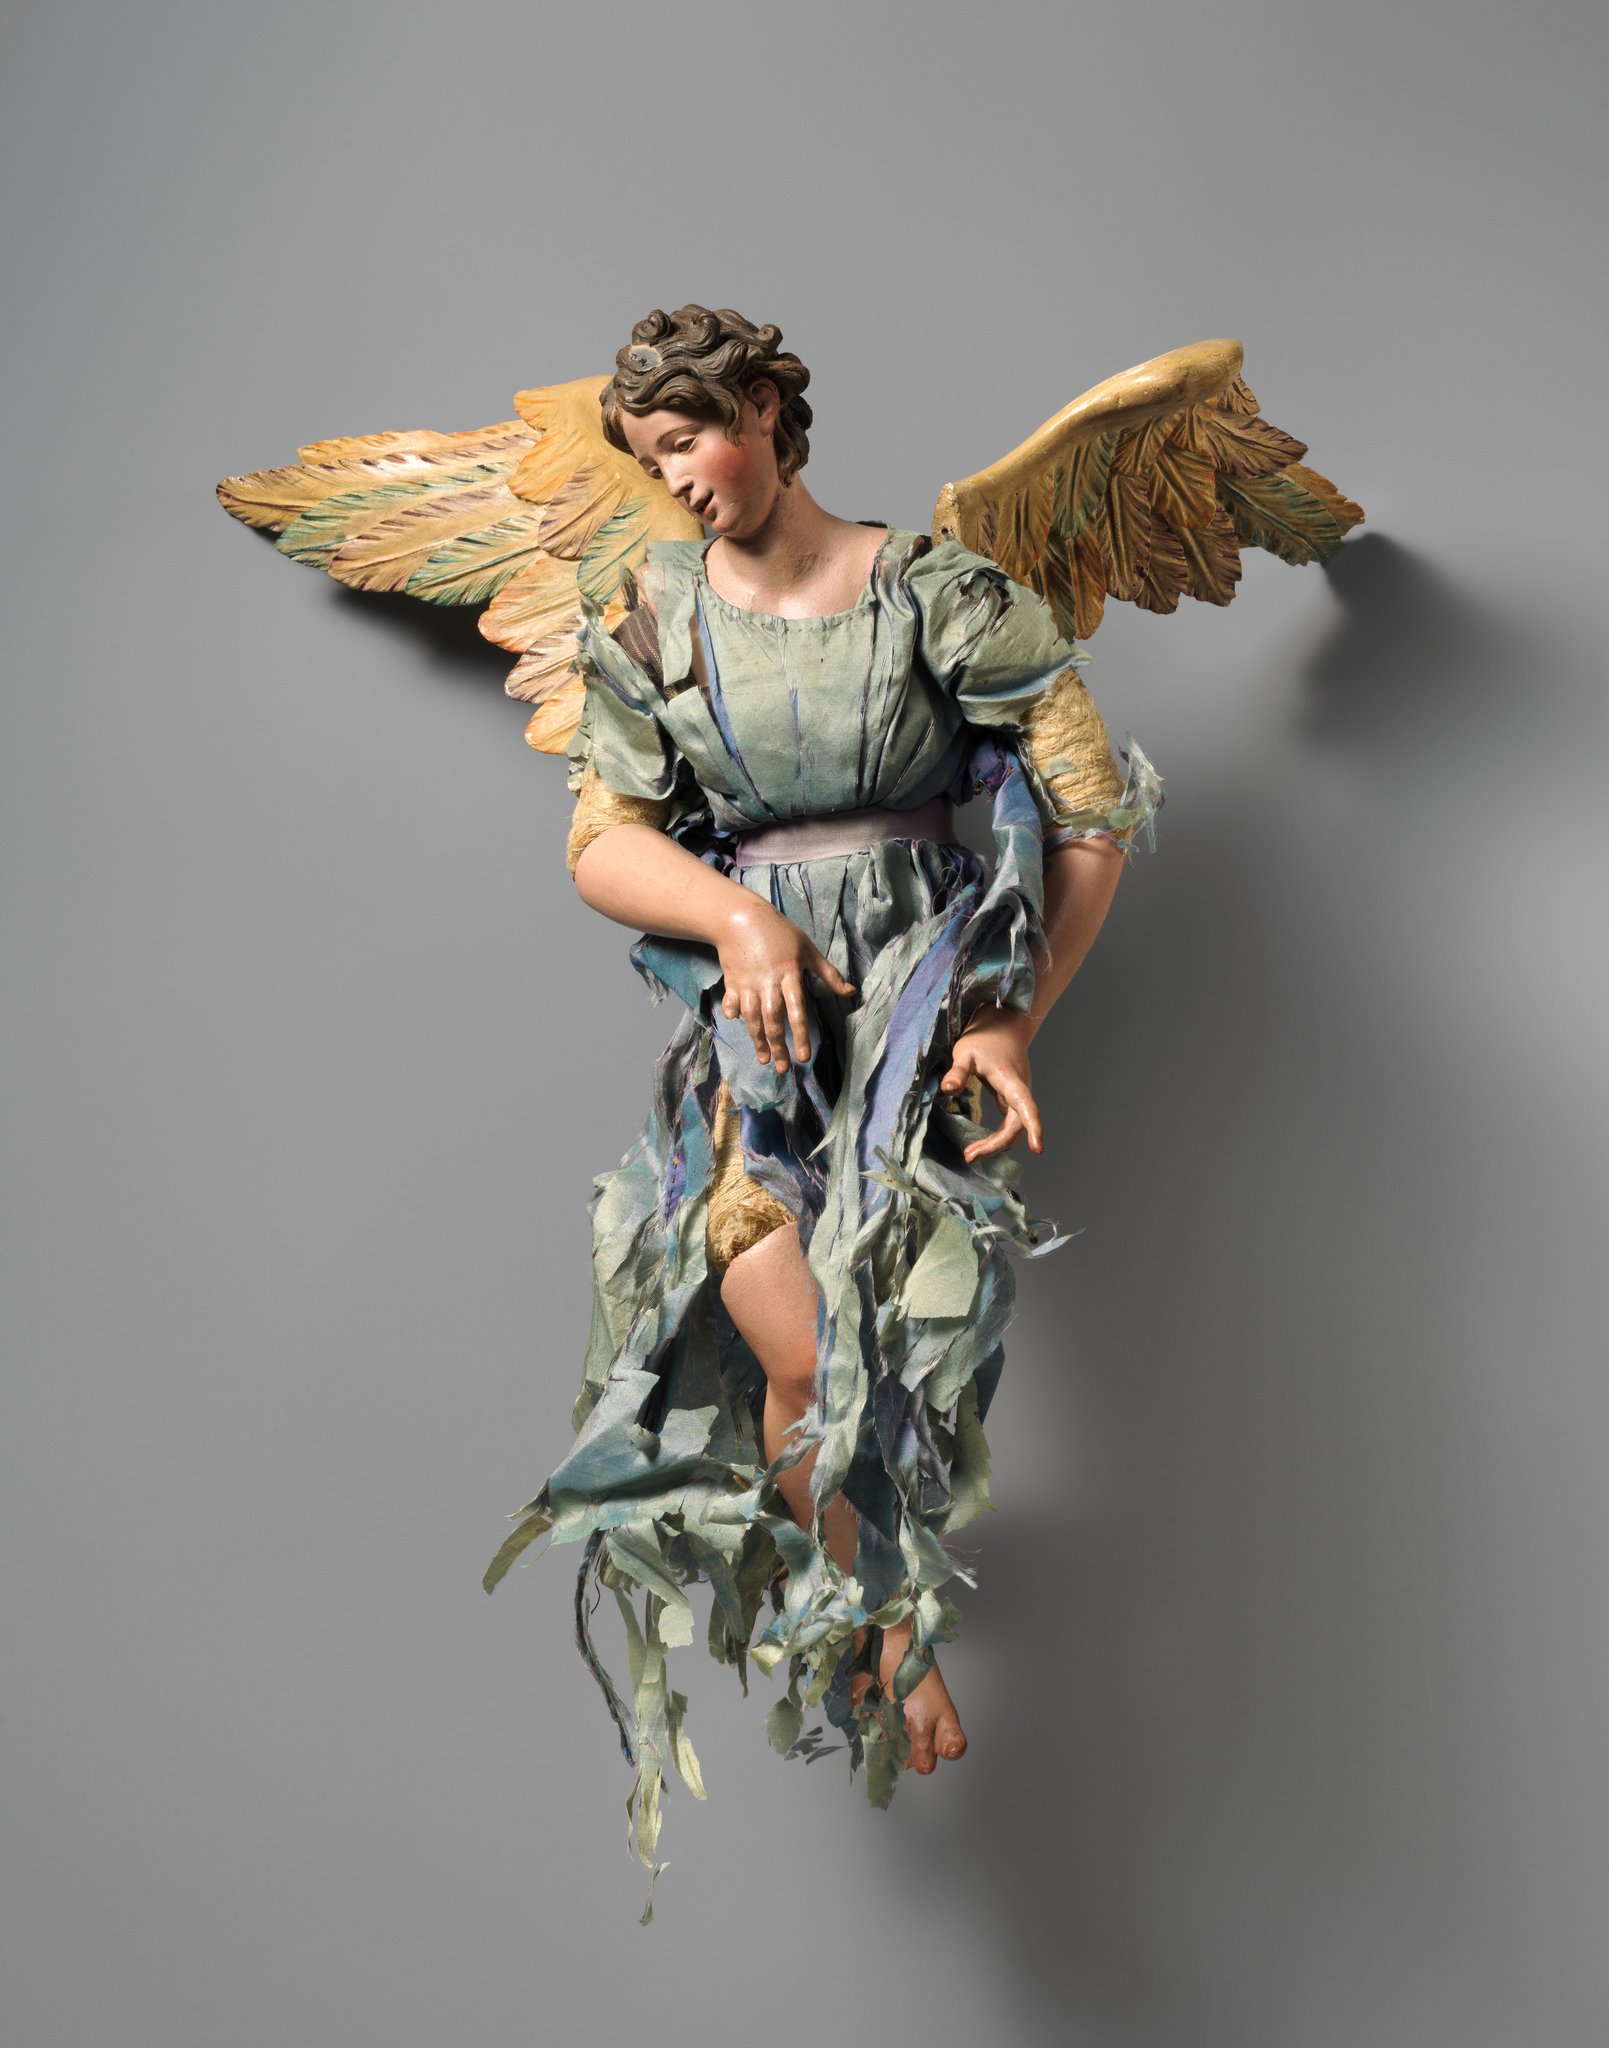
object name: crèche figure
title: Angel with Blue dress (tattered) with detachable wings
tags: angels